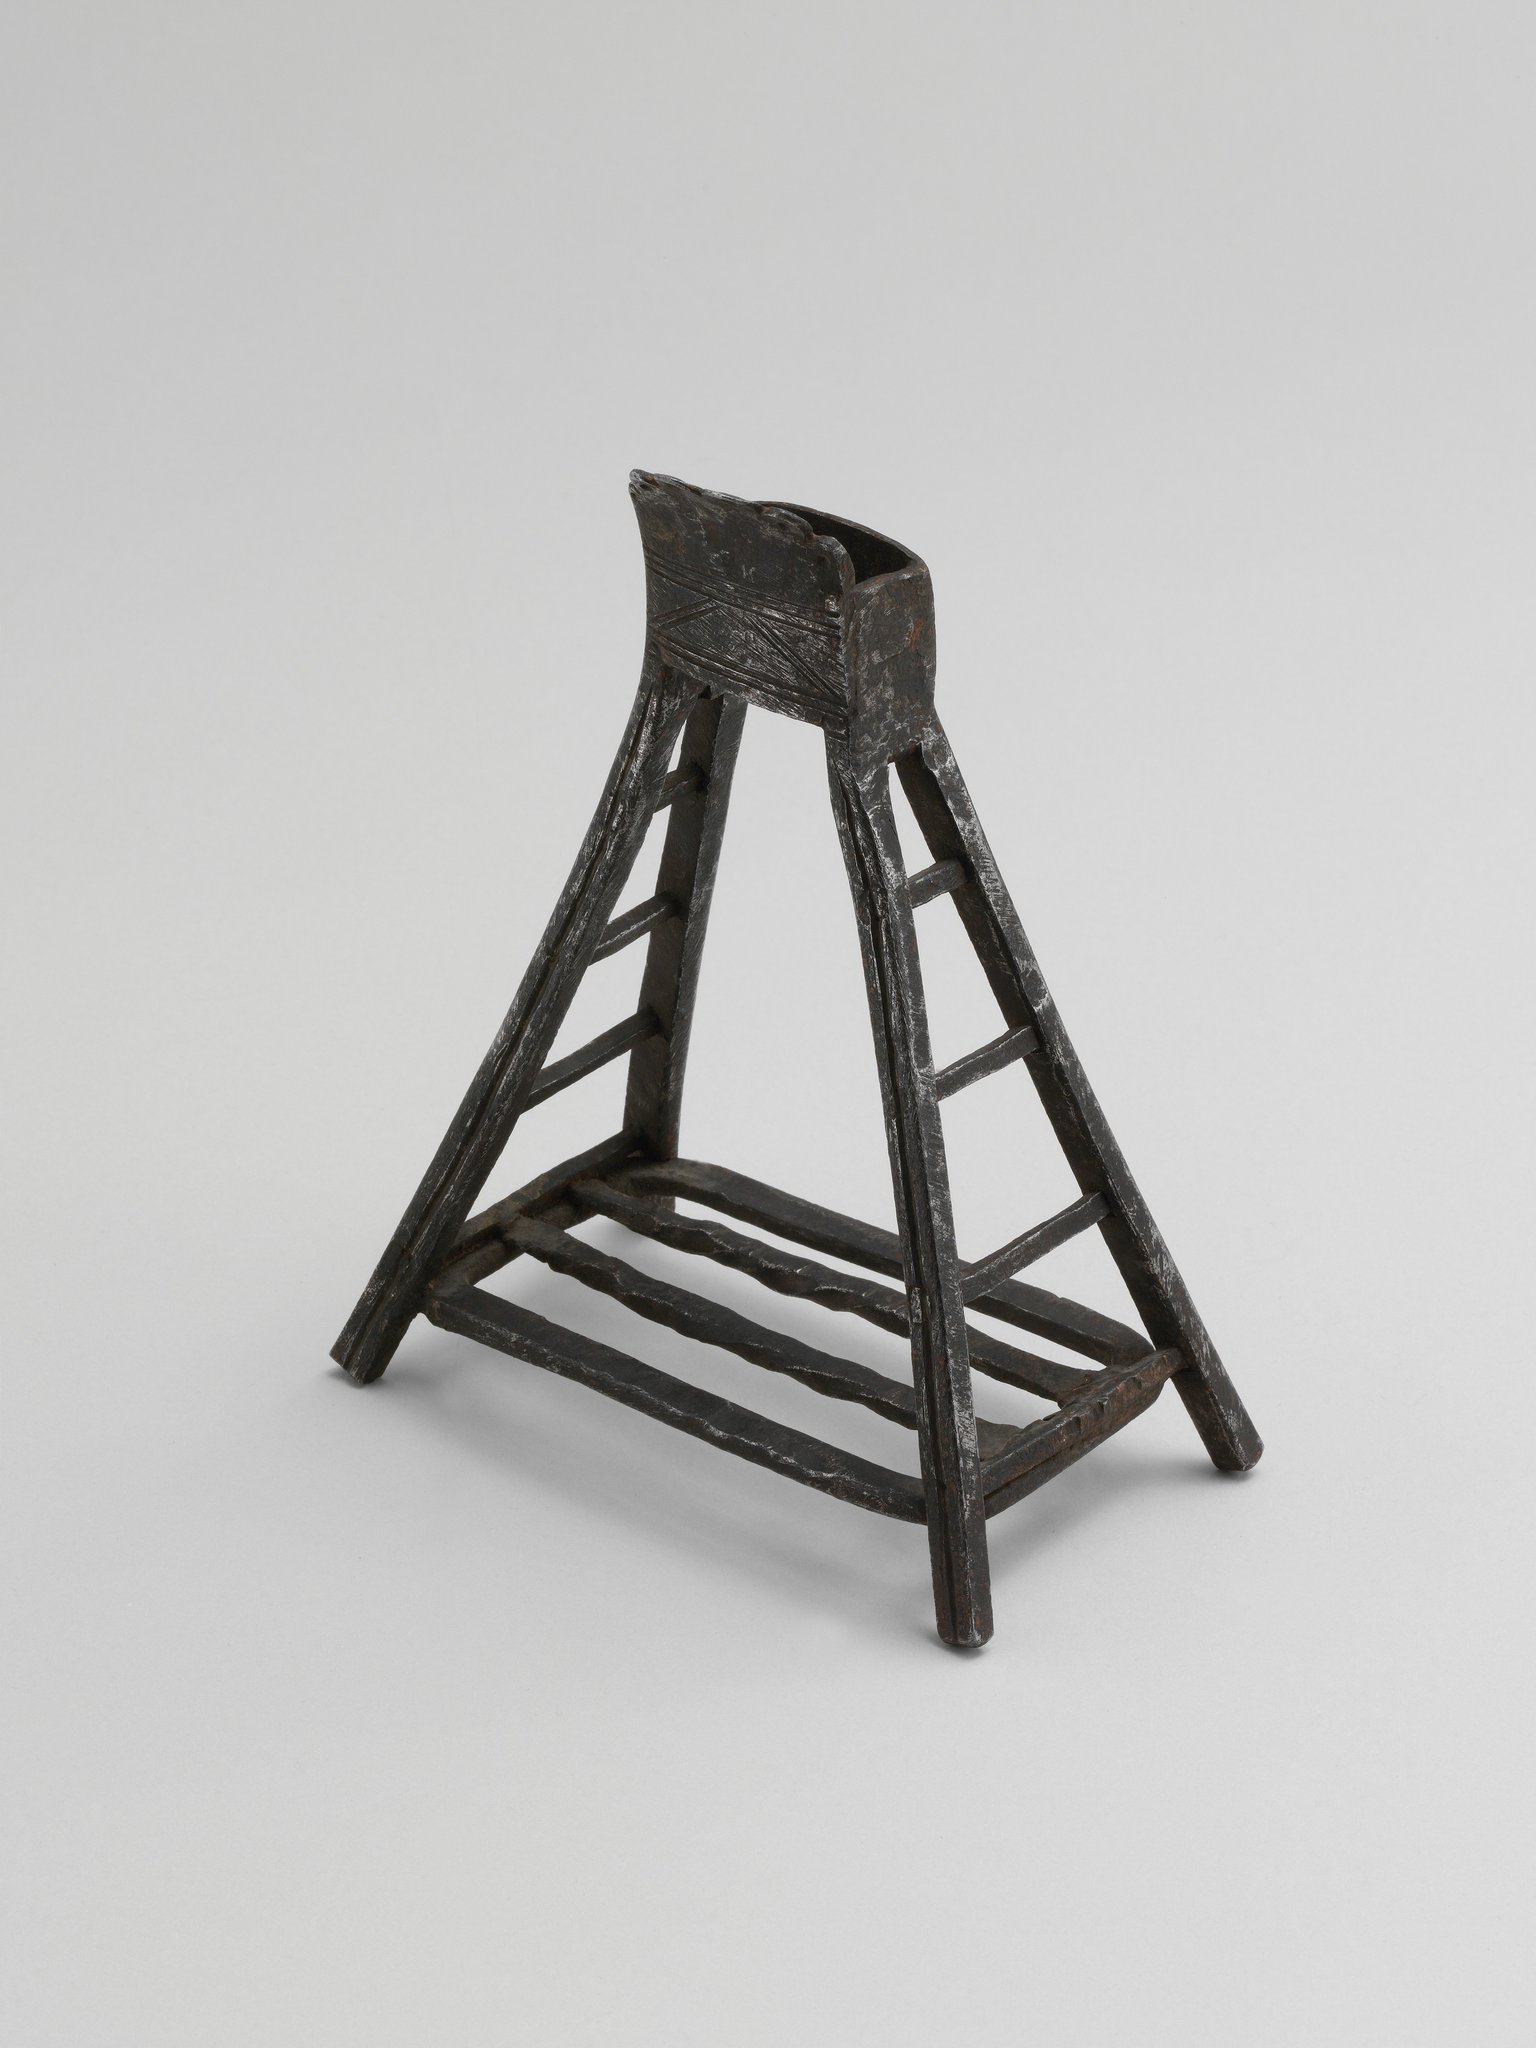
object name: stirrup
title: Stirrup in early 14th Century Italian Style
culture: italian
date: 1801-1900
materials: steel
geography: italy